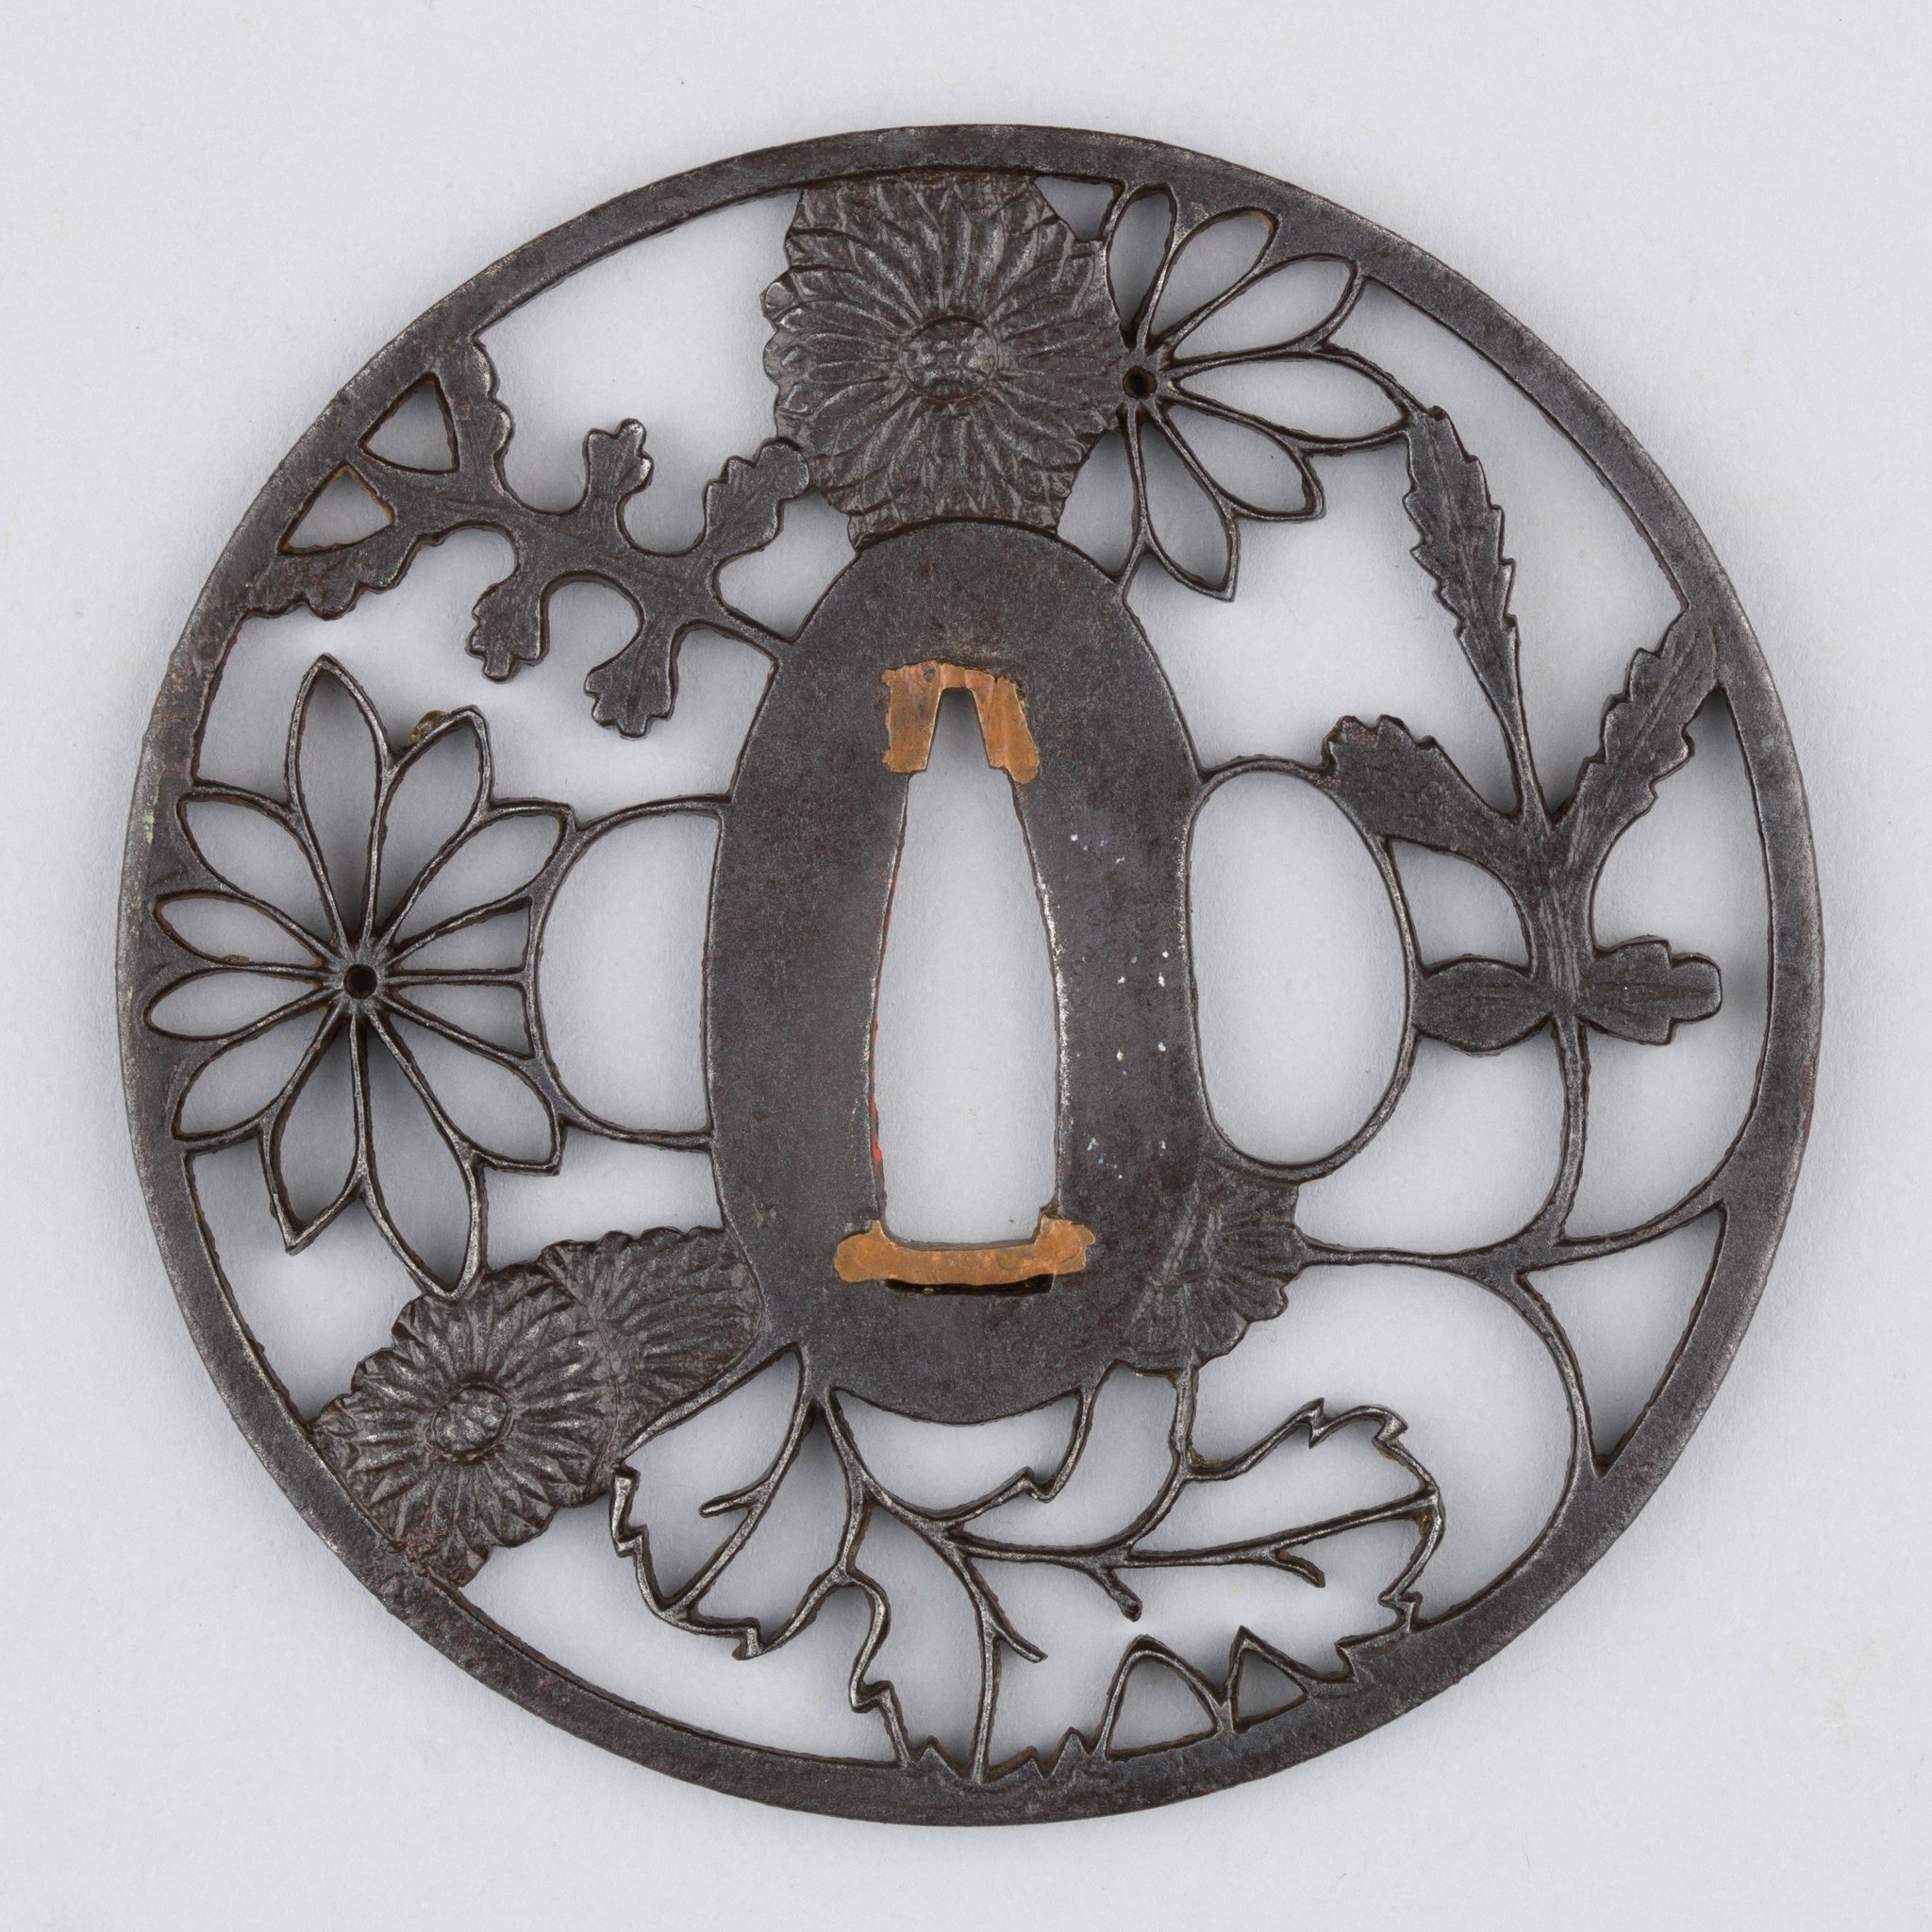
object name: sword guard tsuba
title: Sword Guard (Tsuba)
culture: japanese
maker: hagi school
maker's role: fittings maker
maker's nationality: japanese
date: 1501-1600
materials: iron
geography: japan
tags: flowers